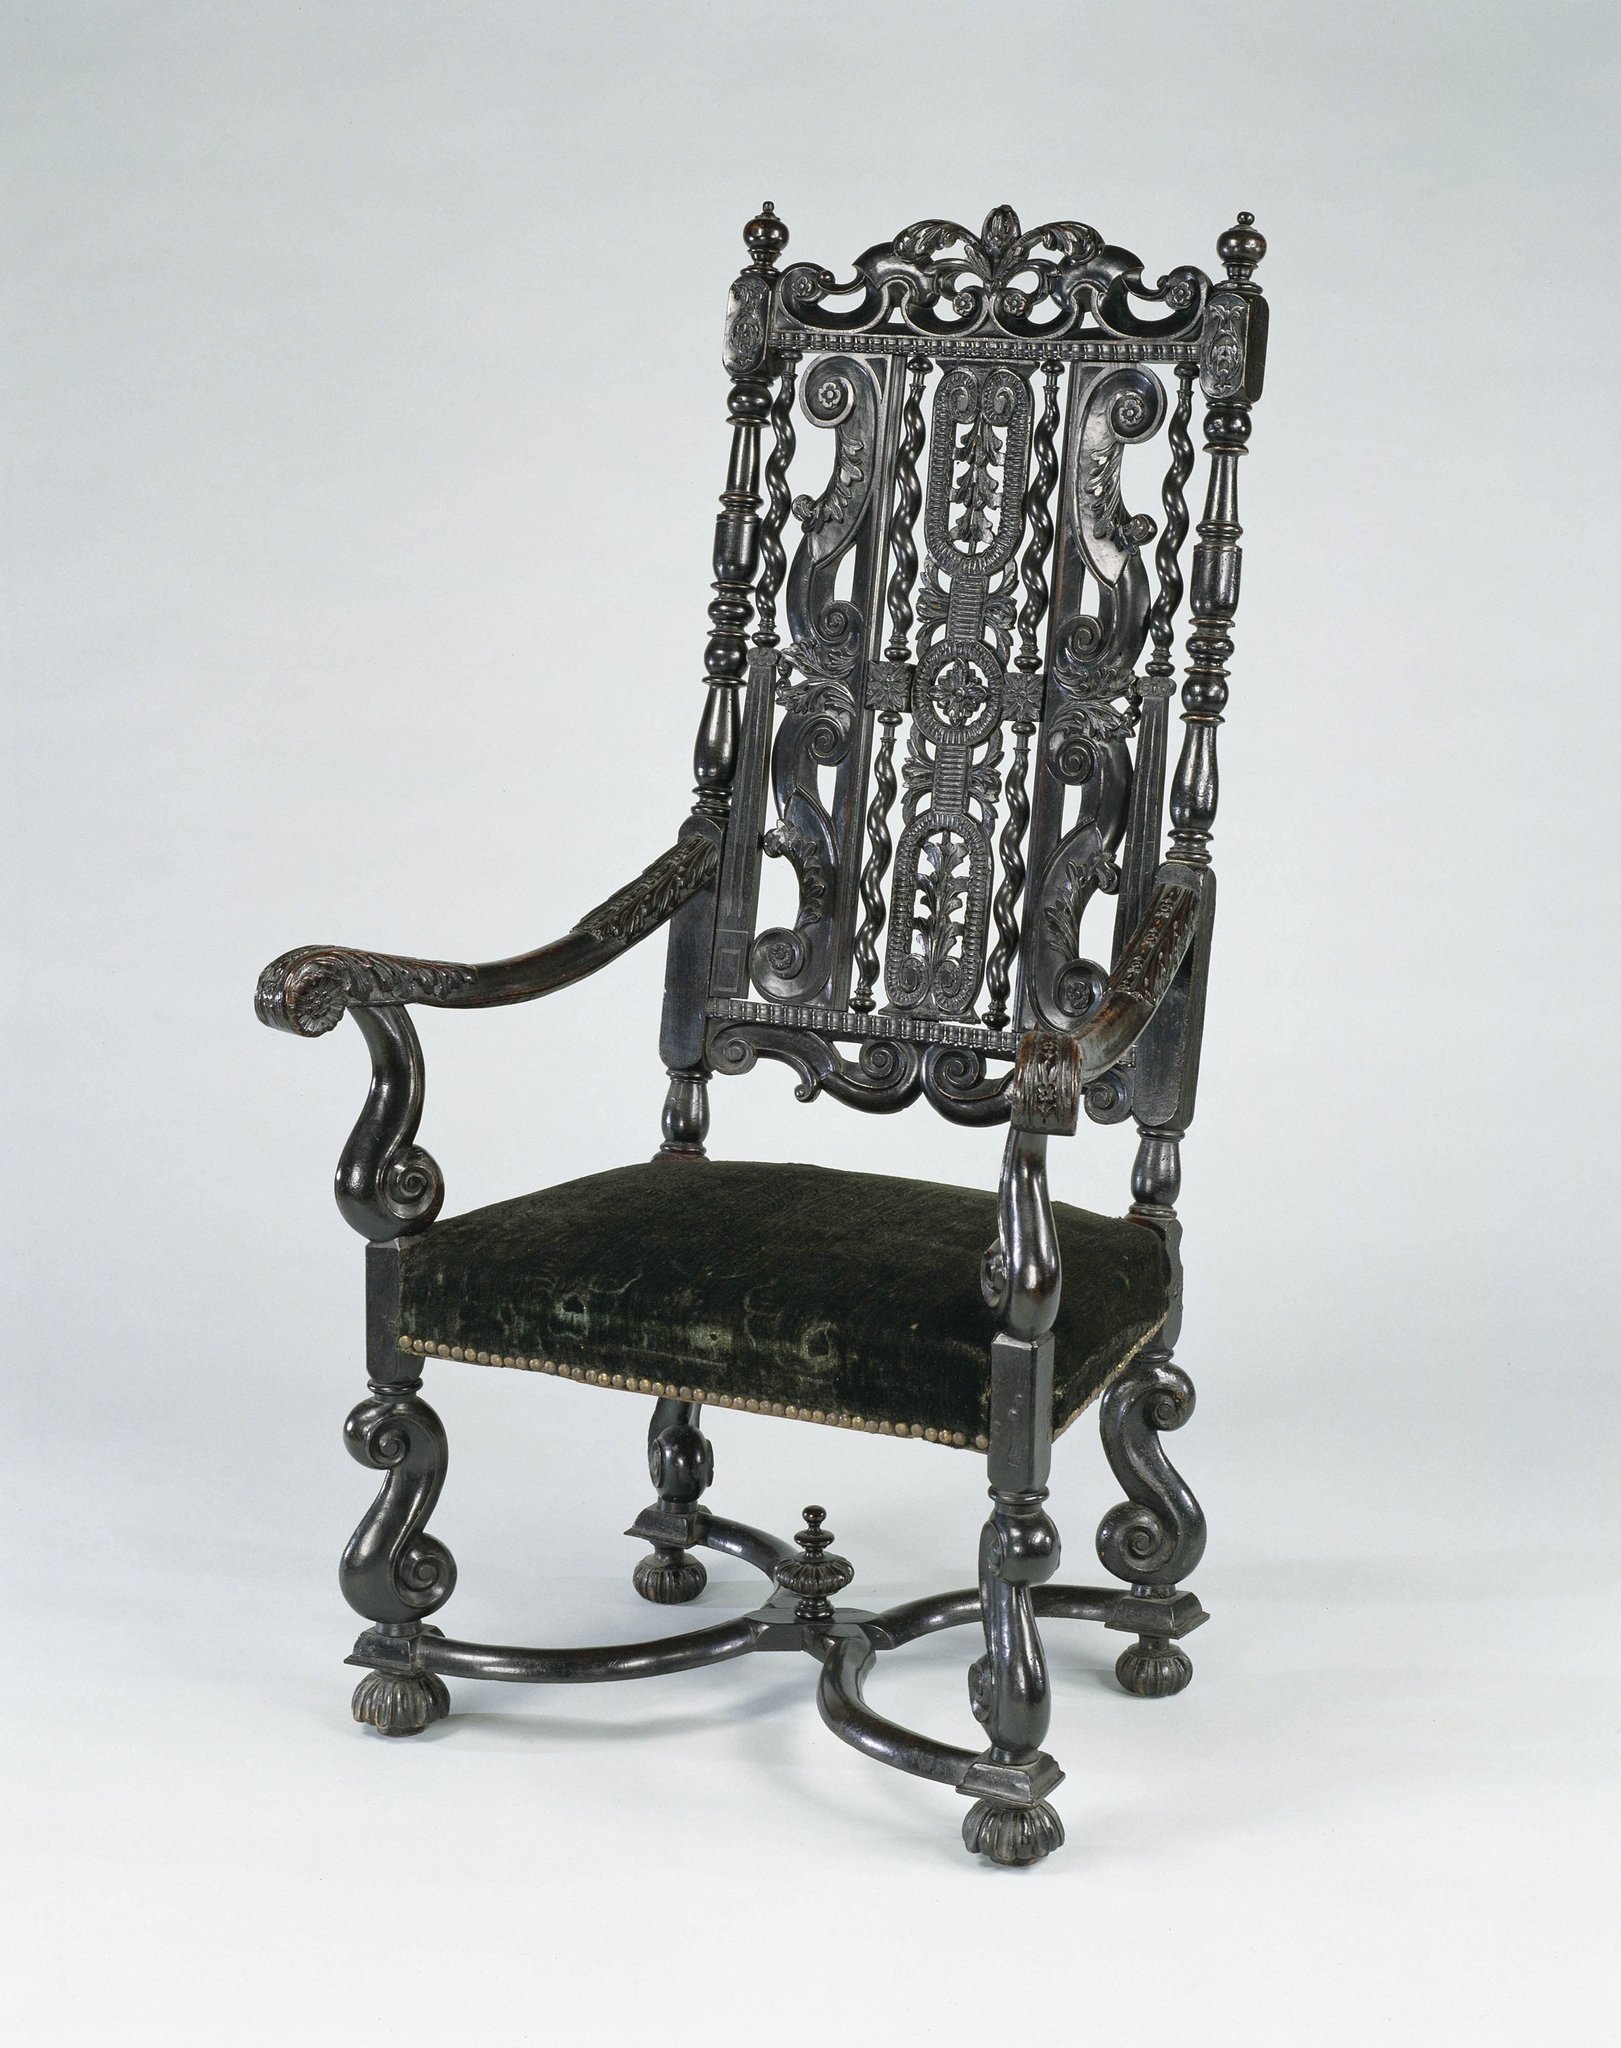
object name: furniture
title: Armstoel van zwartgelakt en -gebeitst notenhout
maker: Anonymous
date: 1675-1700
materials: wood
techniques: lacquer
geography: netherlands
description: Armchair. Walnut, varnished and lacquered black. Northern Netherlands, c. 1700. On loan from the Royal Antiquarian Society.